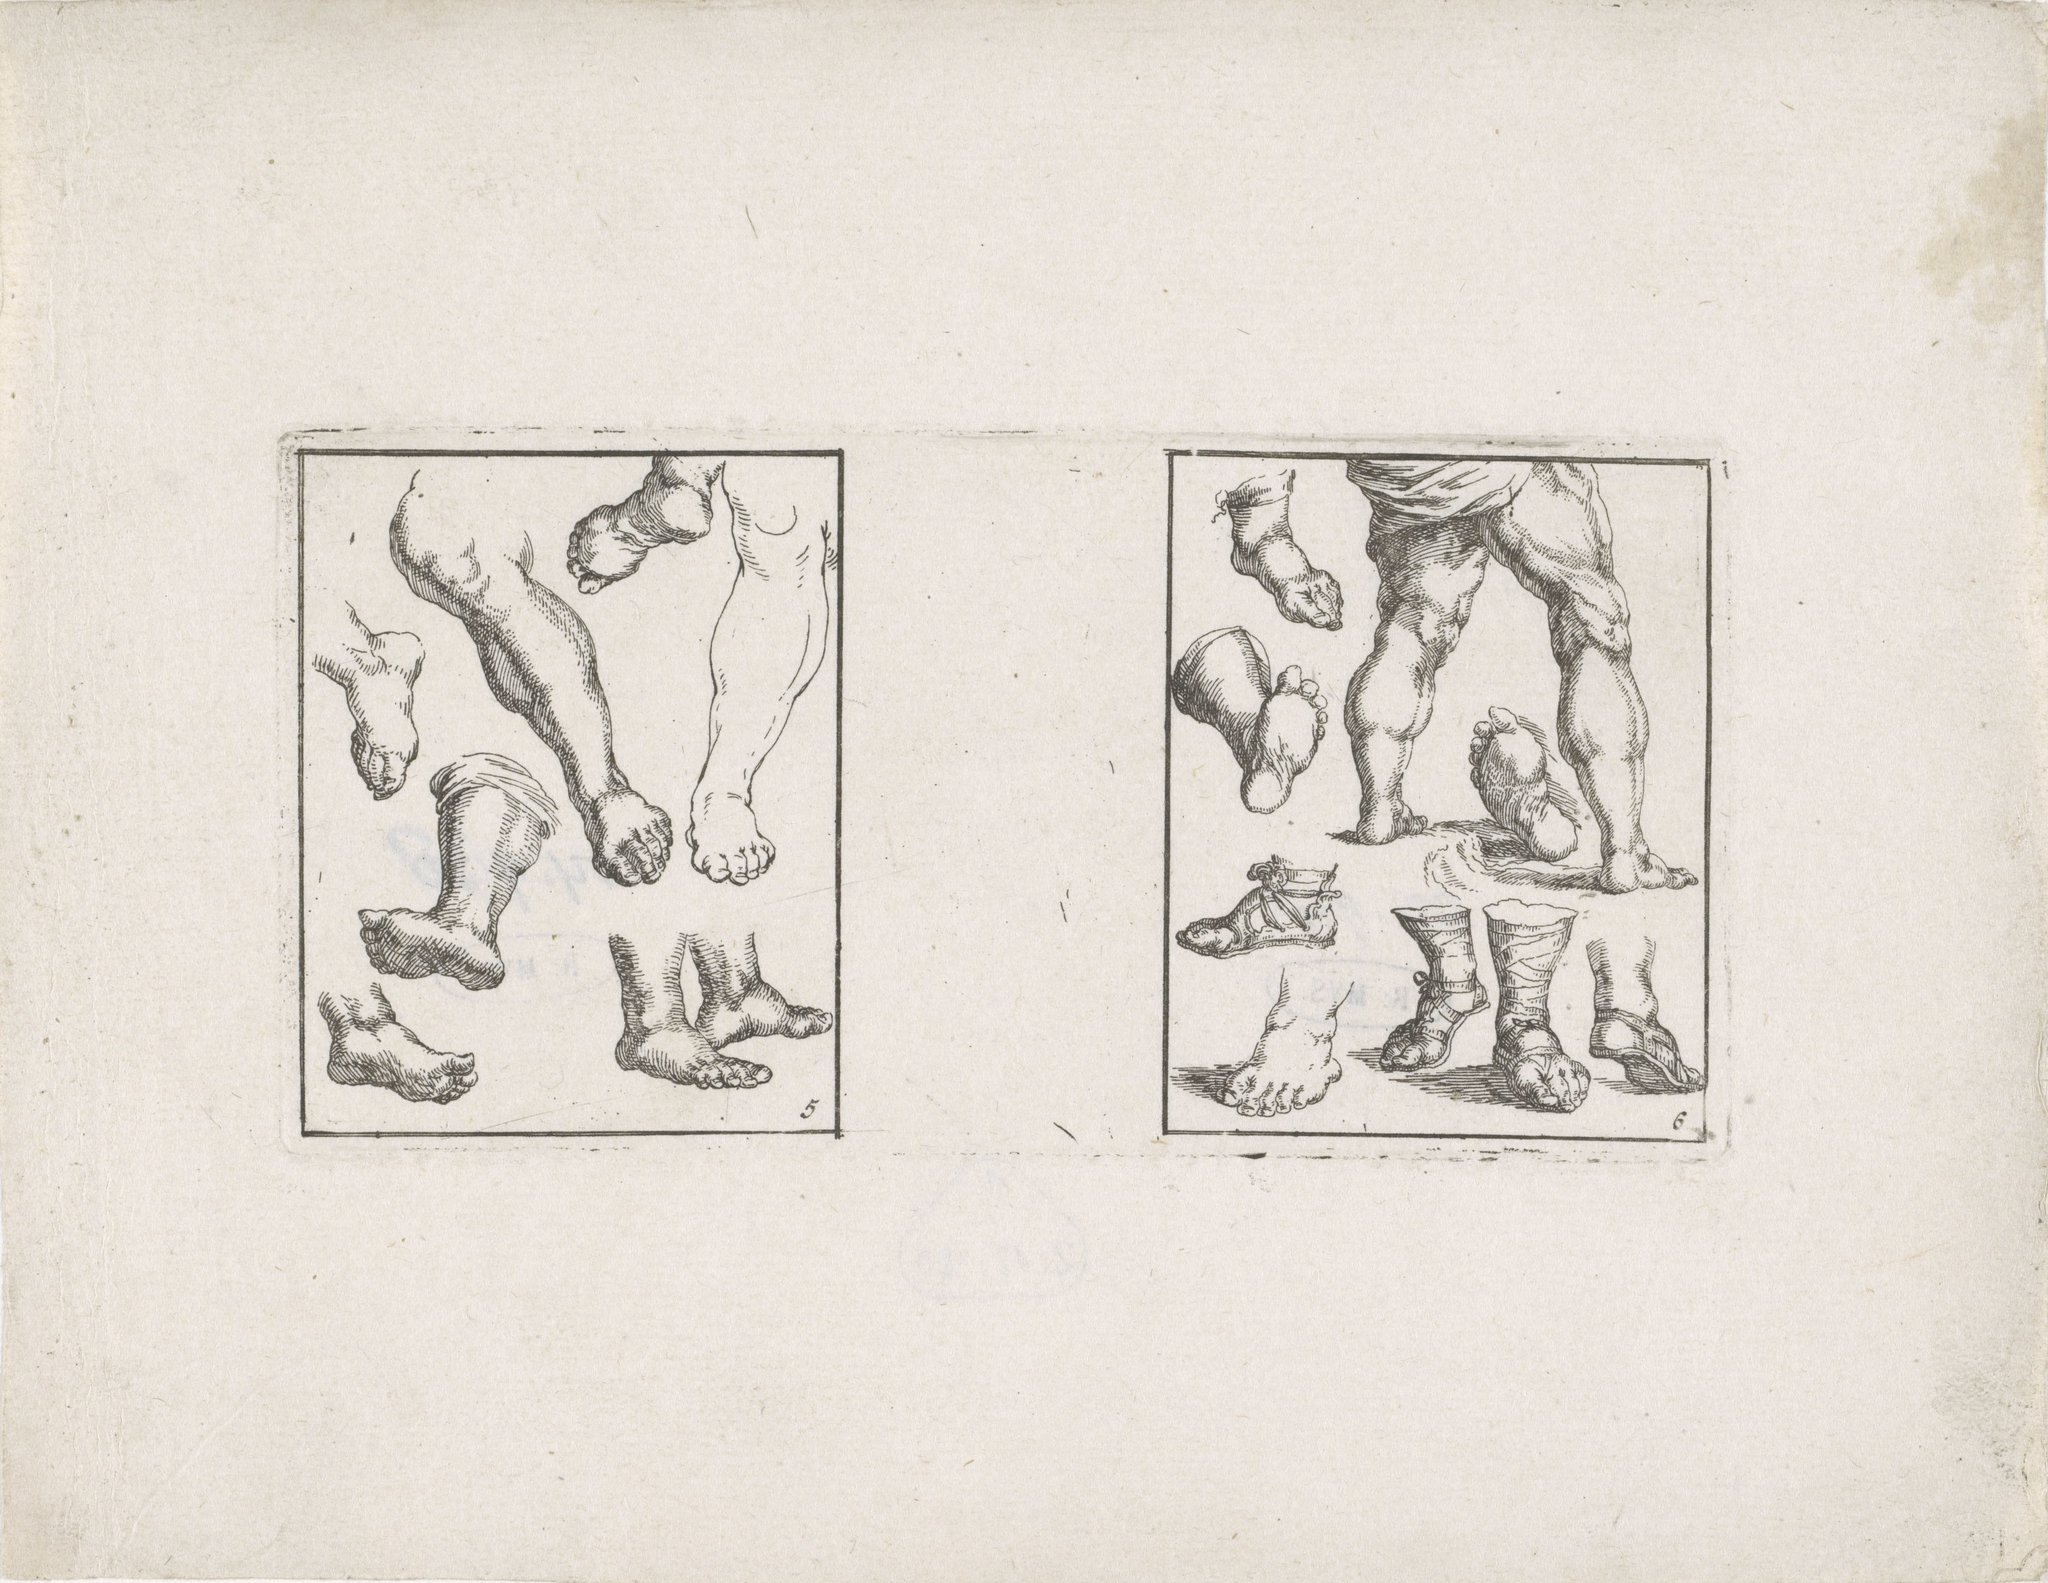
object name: print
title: Tekenvoorbeelden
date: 1620-1664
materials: paper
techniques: etching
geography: amsterdam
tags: foot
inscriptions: collector's mark: Lugt 2228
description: Blad met twee voorstellingen. Links: acht voeten, waarvan twee met been tot aan knie. Rechts: tien voeten, waarvan twee met volledige benen.